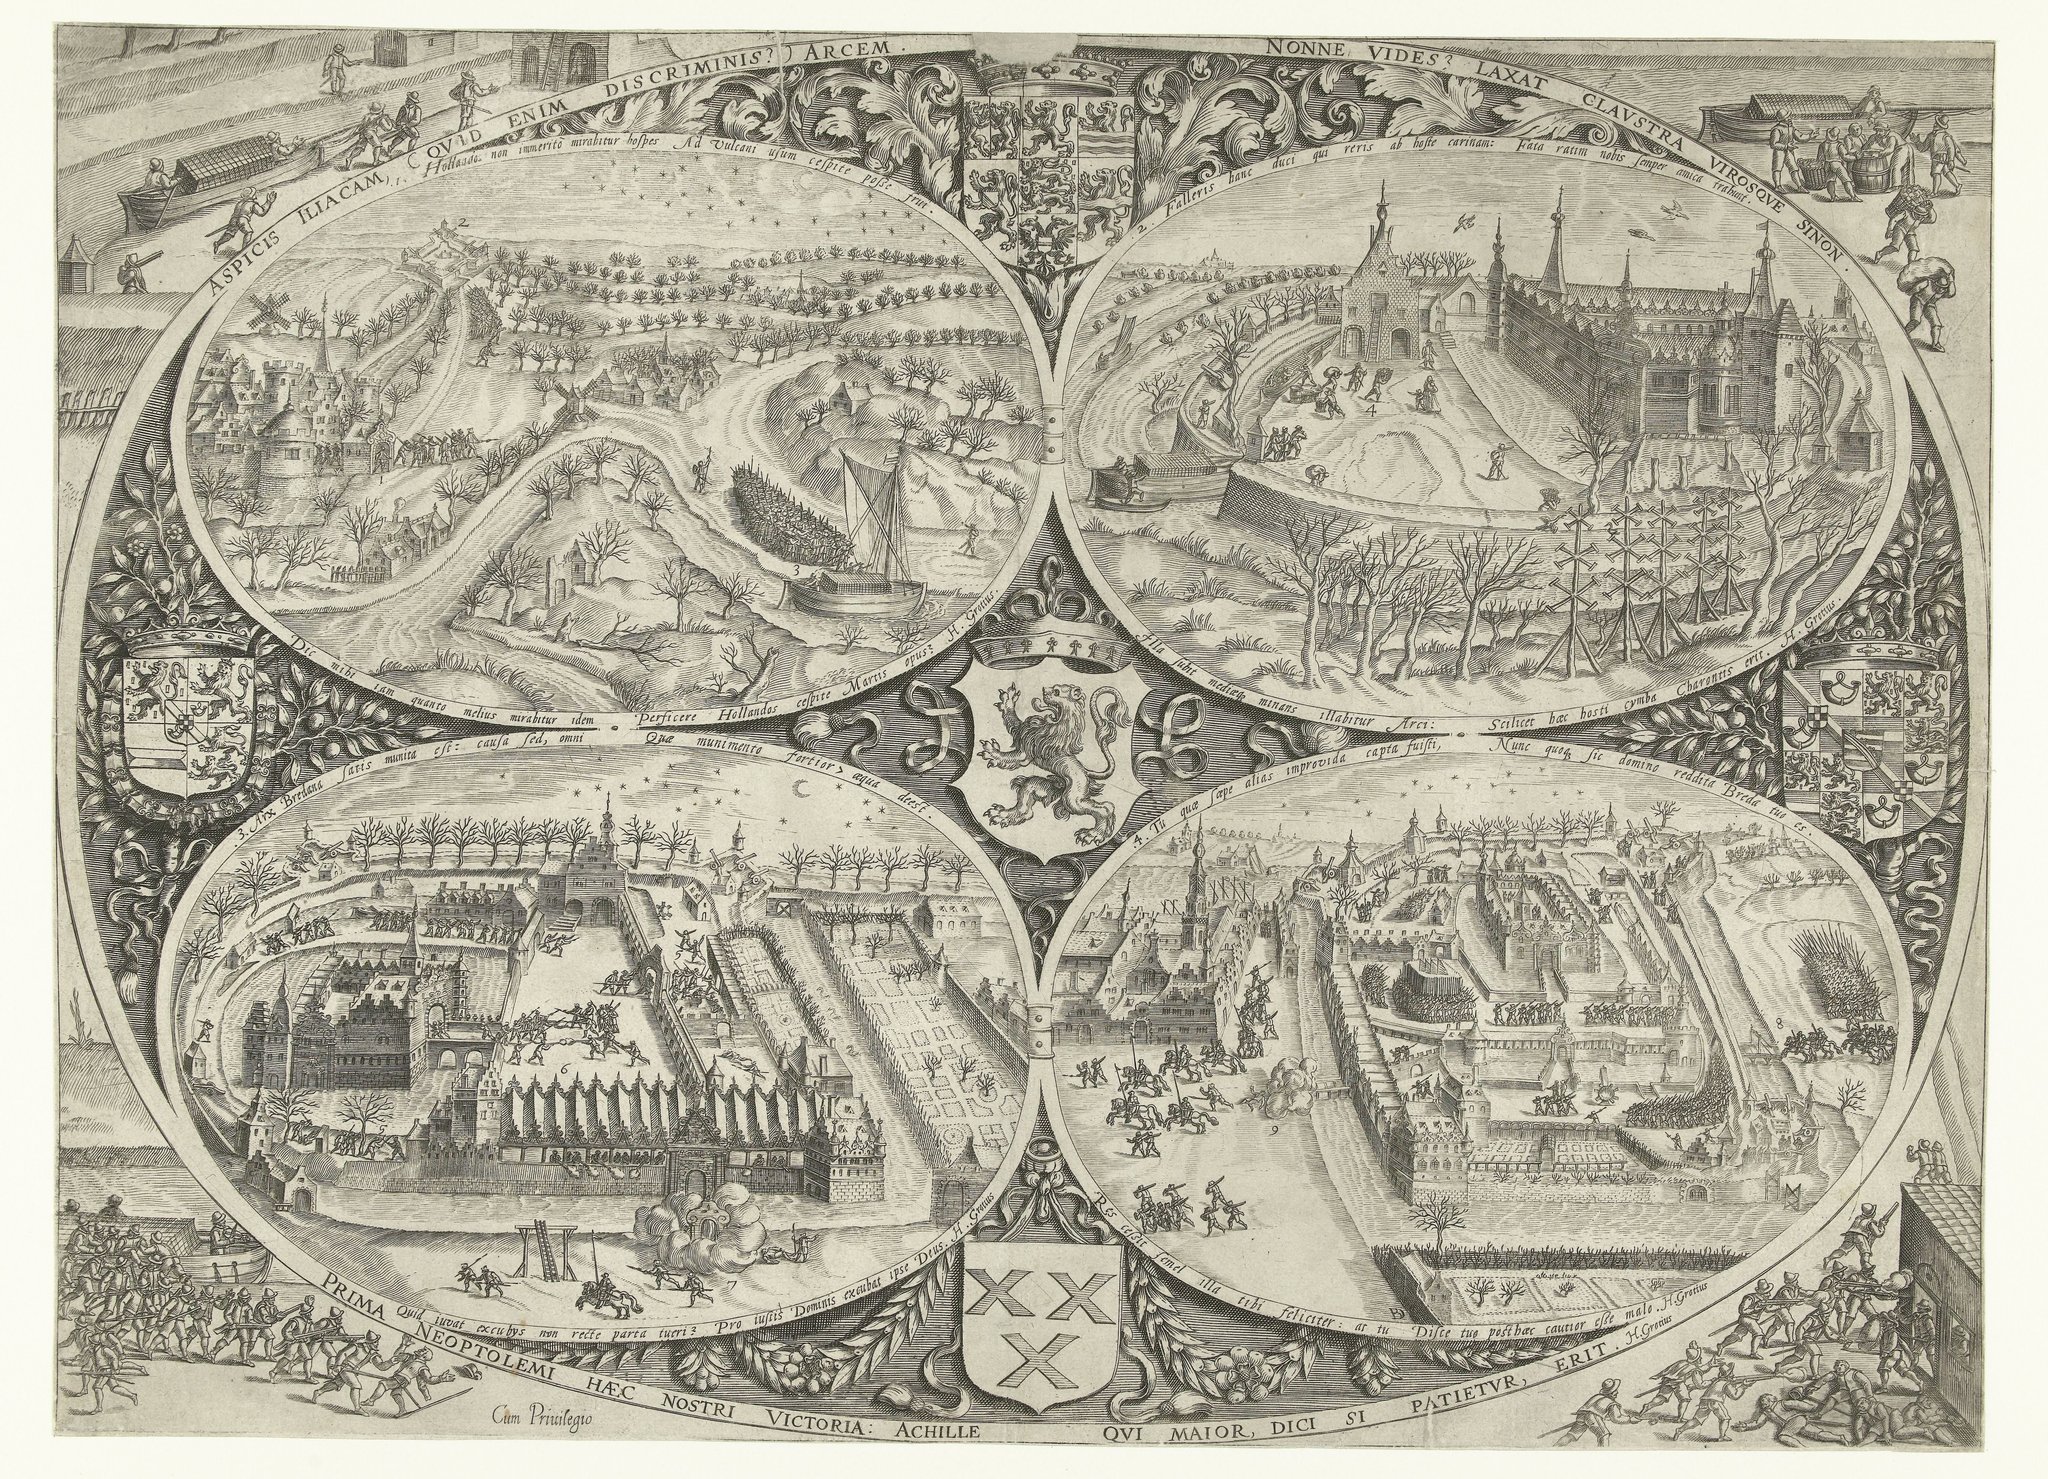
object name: print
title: Inname van Breda, 1590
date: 1597-1601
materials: paper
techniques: engraving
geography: northern netherlands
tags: the hague, maurice (prince of orange), capture of city (after the siege)